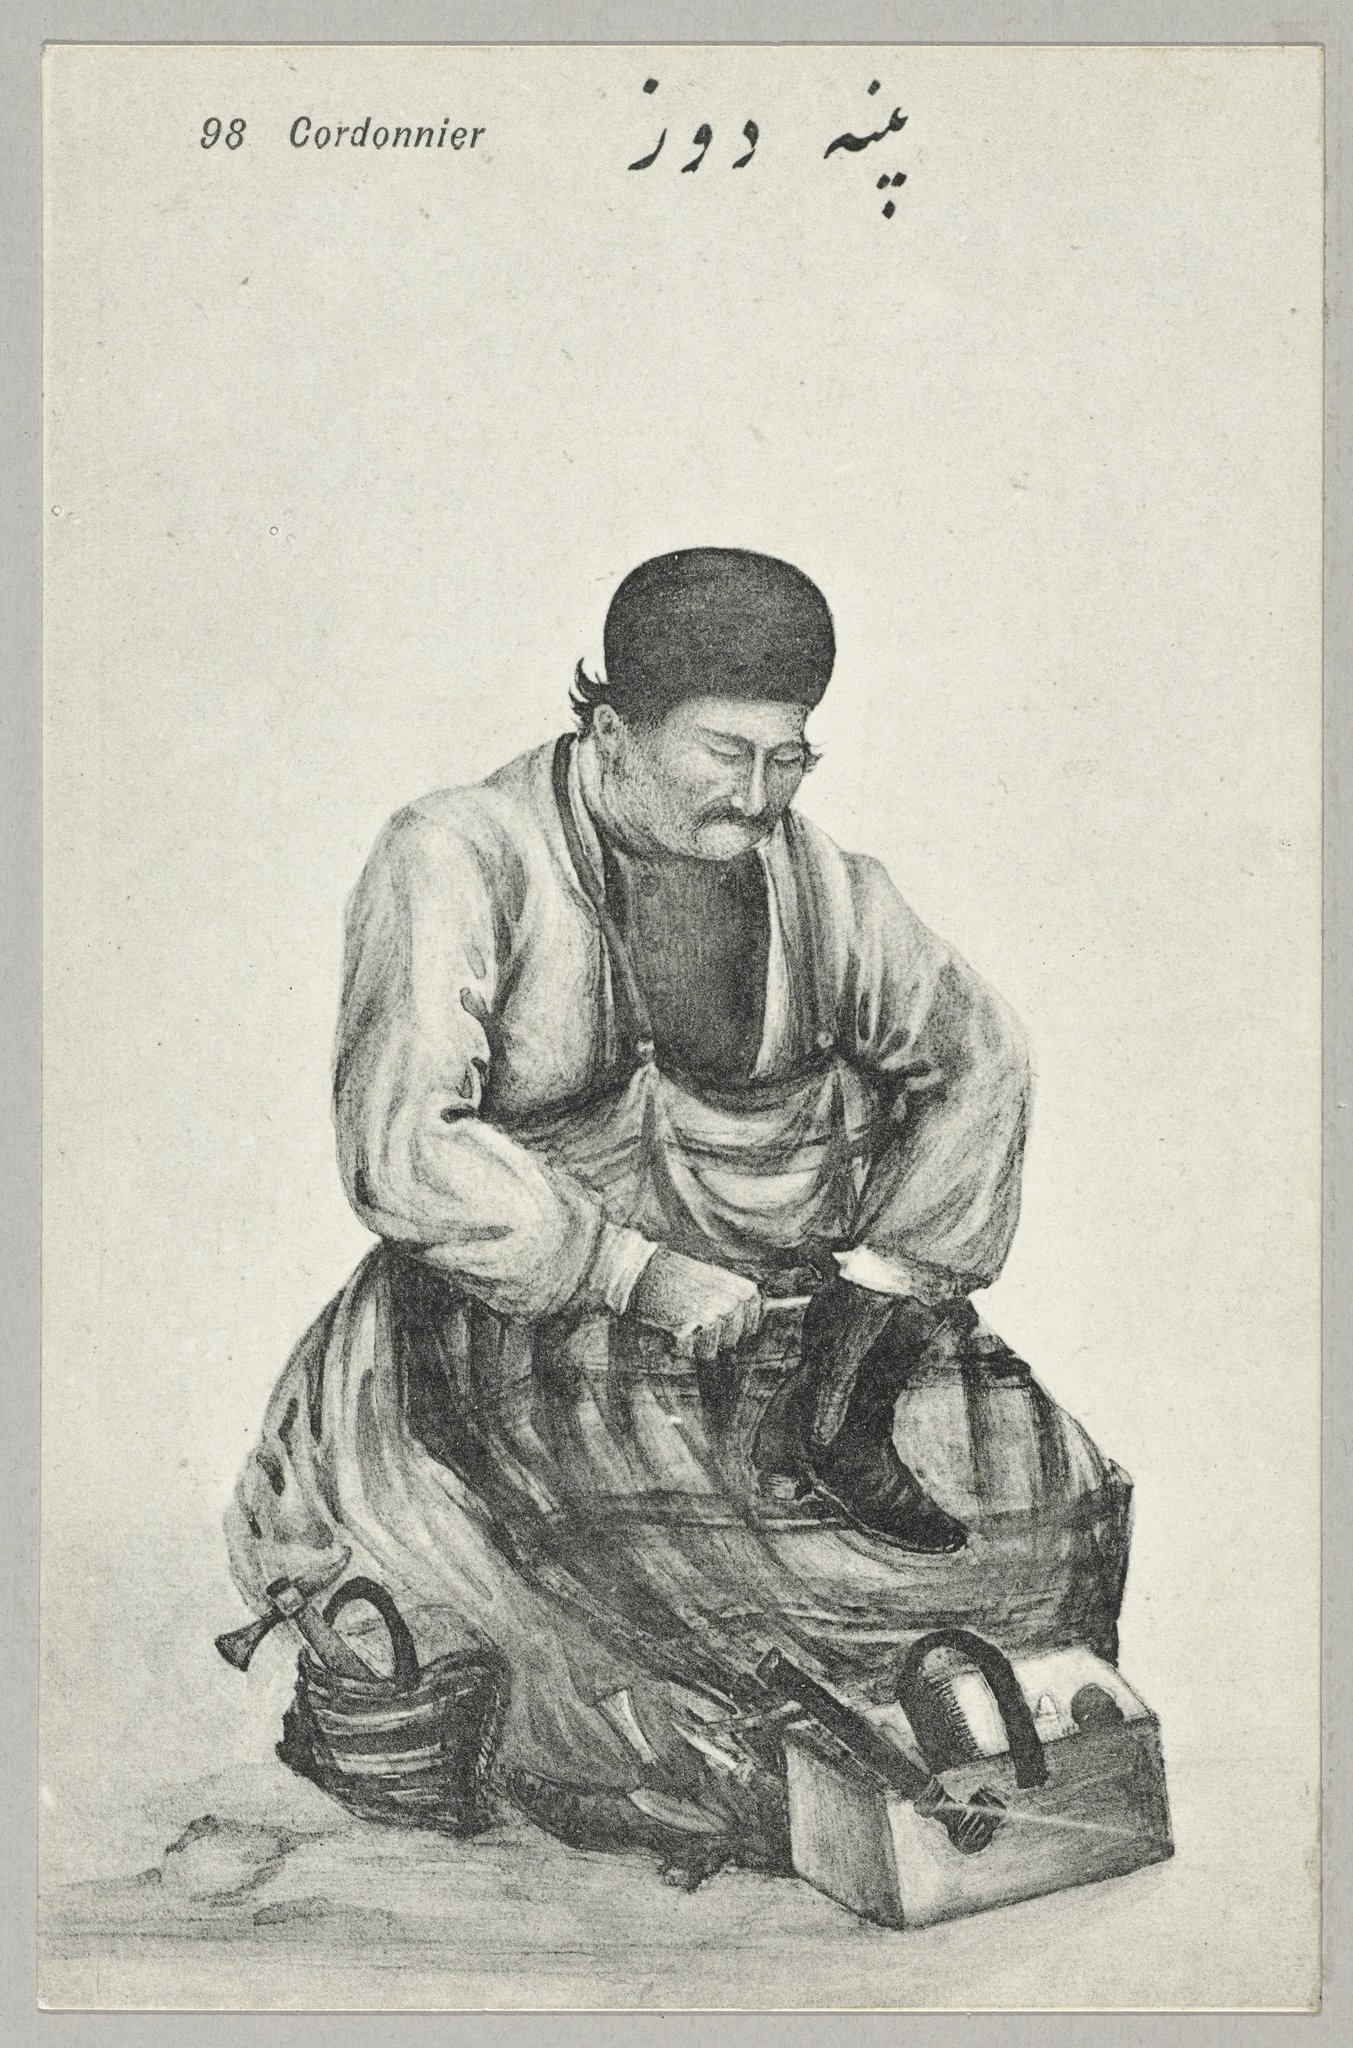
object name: photomechanical print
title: 98 Cordonnier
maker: Anonymous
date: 1895-1915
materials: cardboard, paper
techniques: photograph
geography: tabriz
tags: tabriz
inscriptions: annotation: ‘34. Tabris’